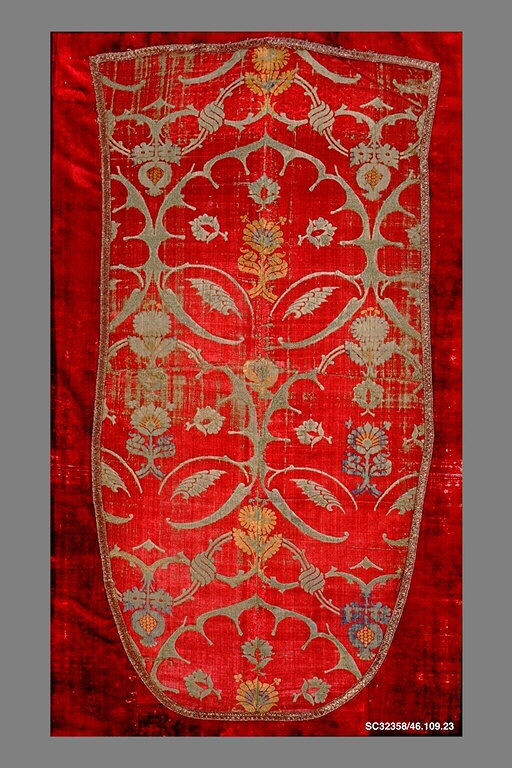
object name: panel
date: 1500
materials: silk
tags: flowers